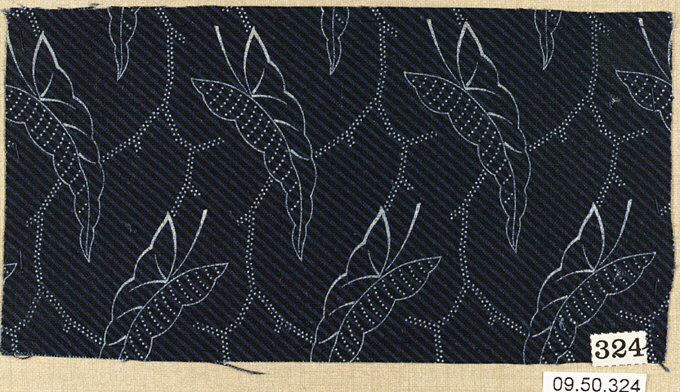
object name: piece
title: Piece (one of 116)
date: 1801-1900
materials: cotton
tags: leaves